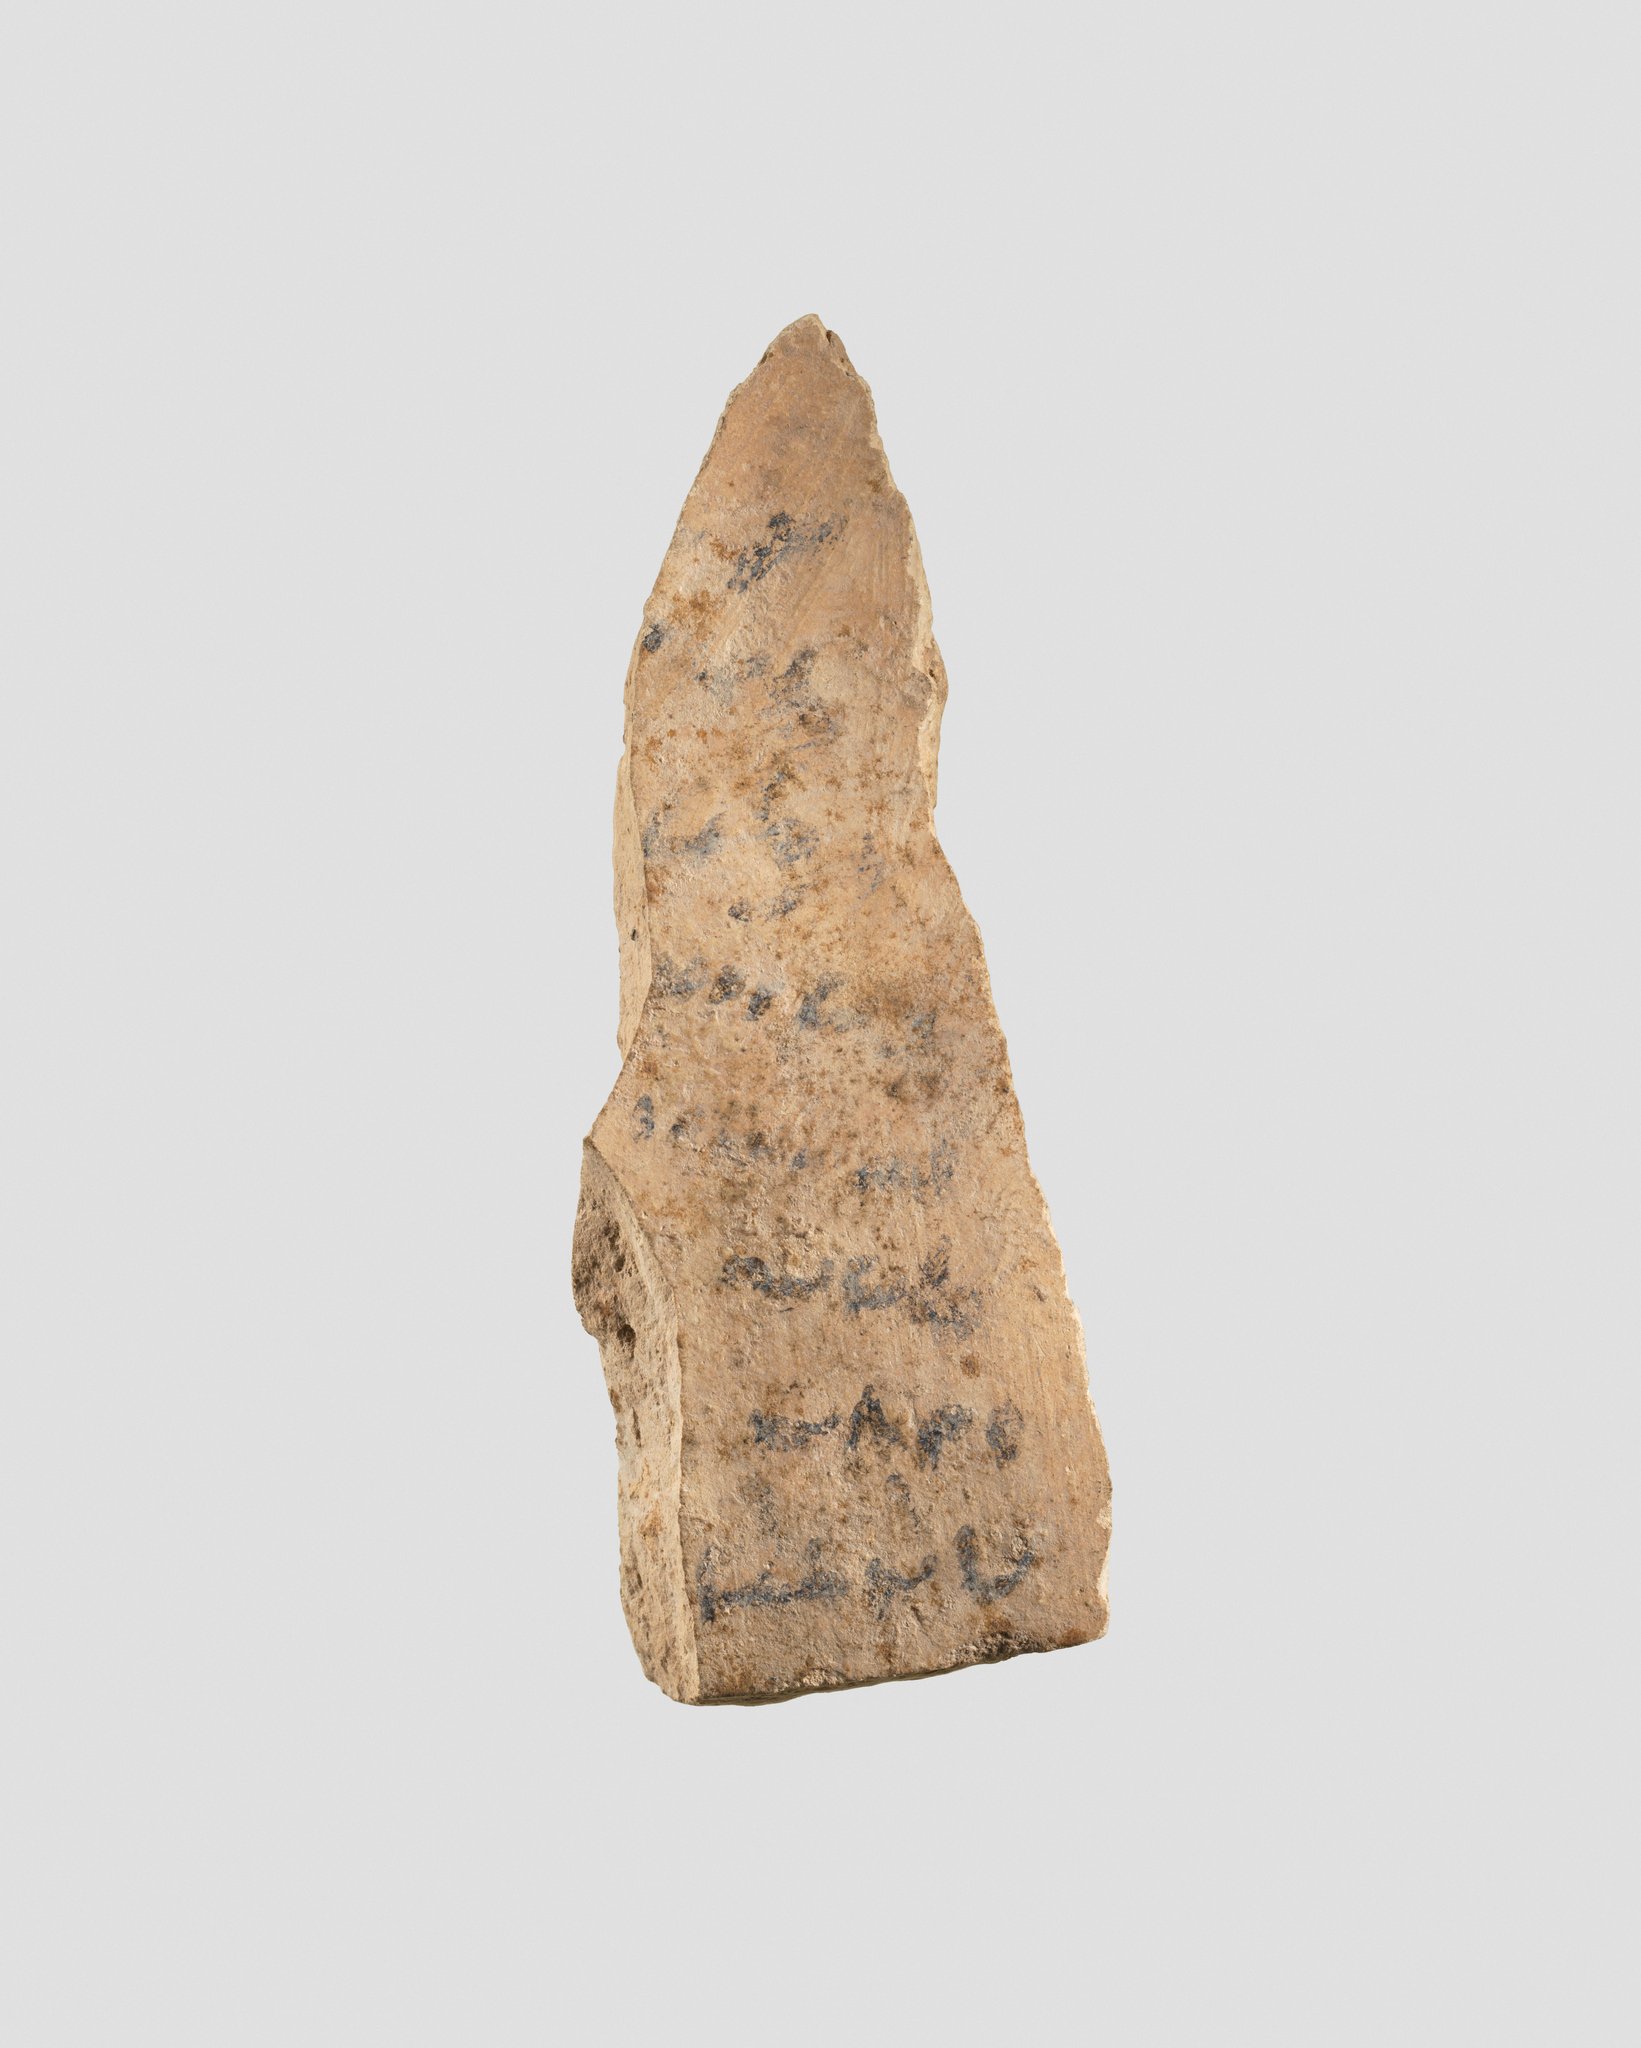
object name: sherd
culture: sasanian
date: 201-700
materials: ceramic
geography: iran